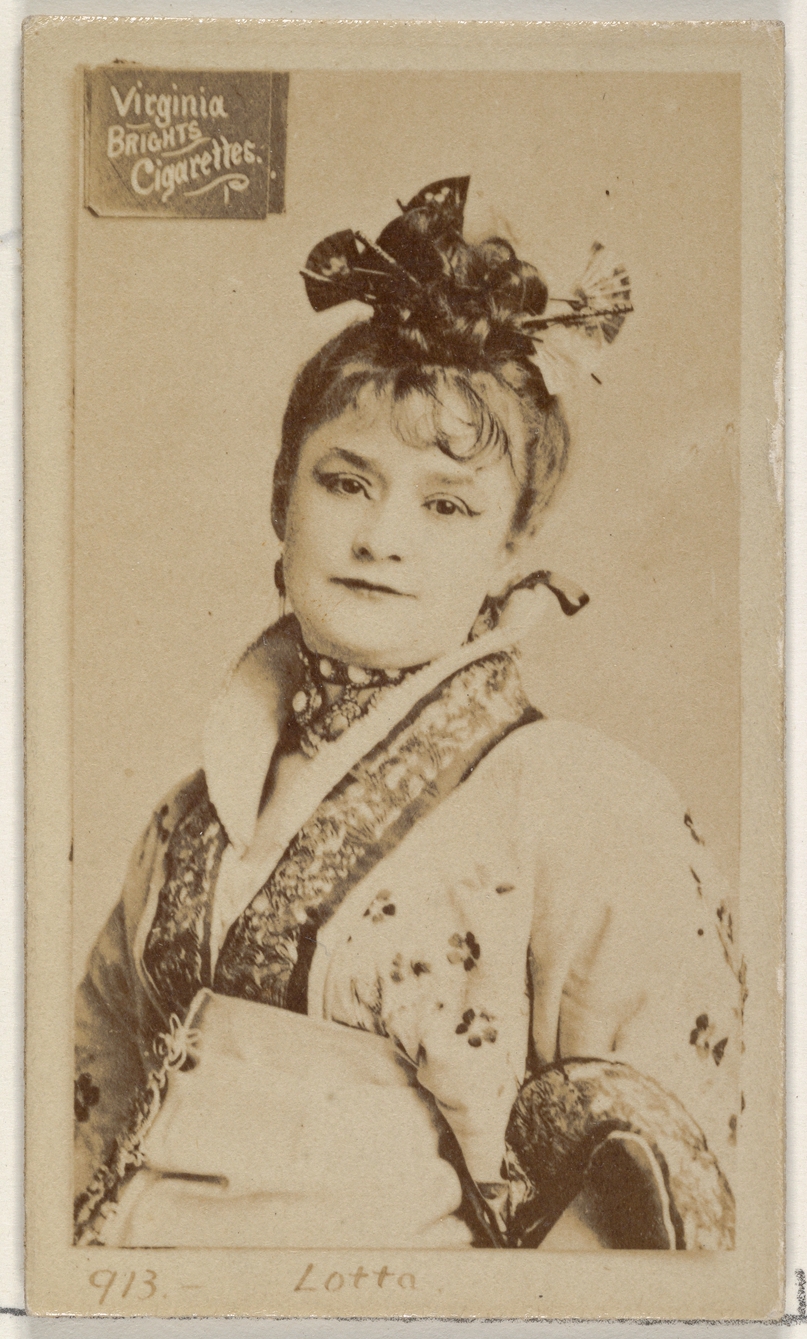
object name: photograph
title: Card 913, Lotta, from the Actors and Actresses series (N45, Type 2) for Virginia Brights Cigarettes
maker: allen & ginter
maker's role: publisher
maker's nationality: american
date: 1888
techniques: albumen silver print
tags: portraits,women,actresses